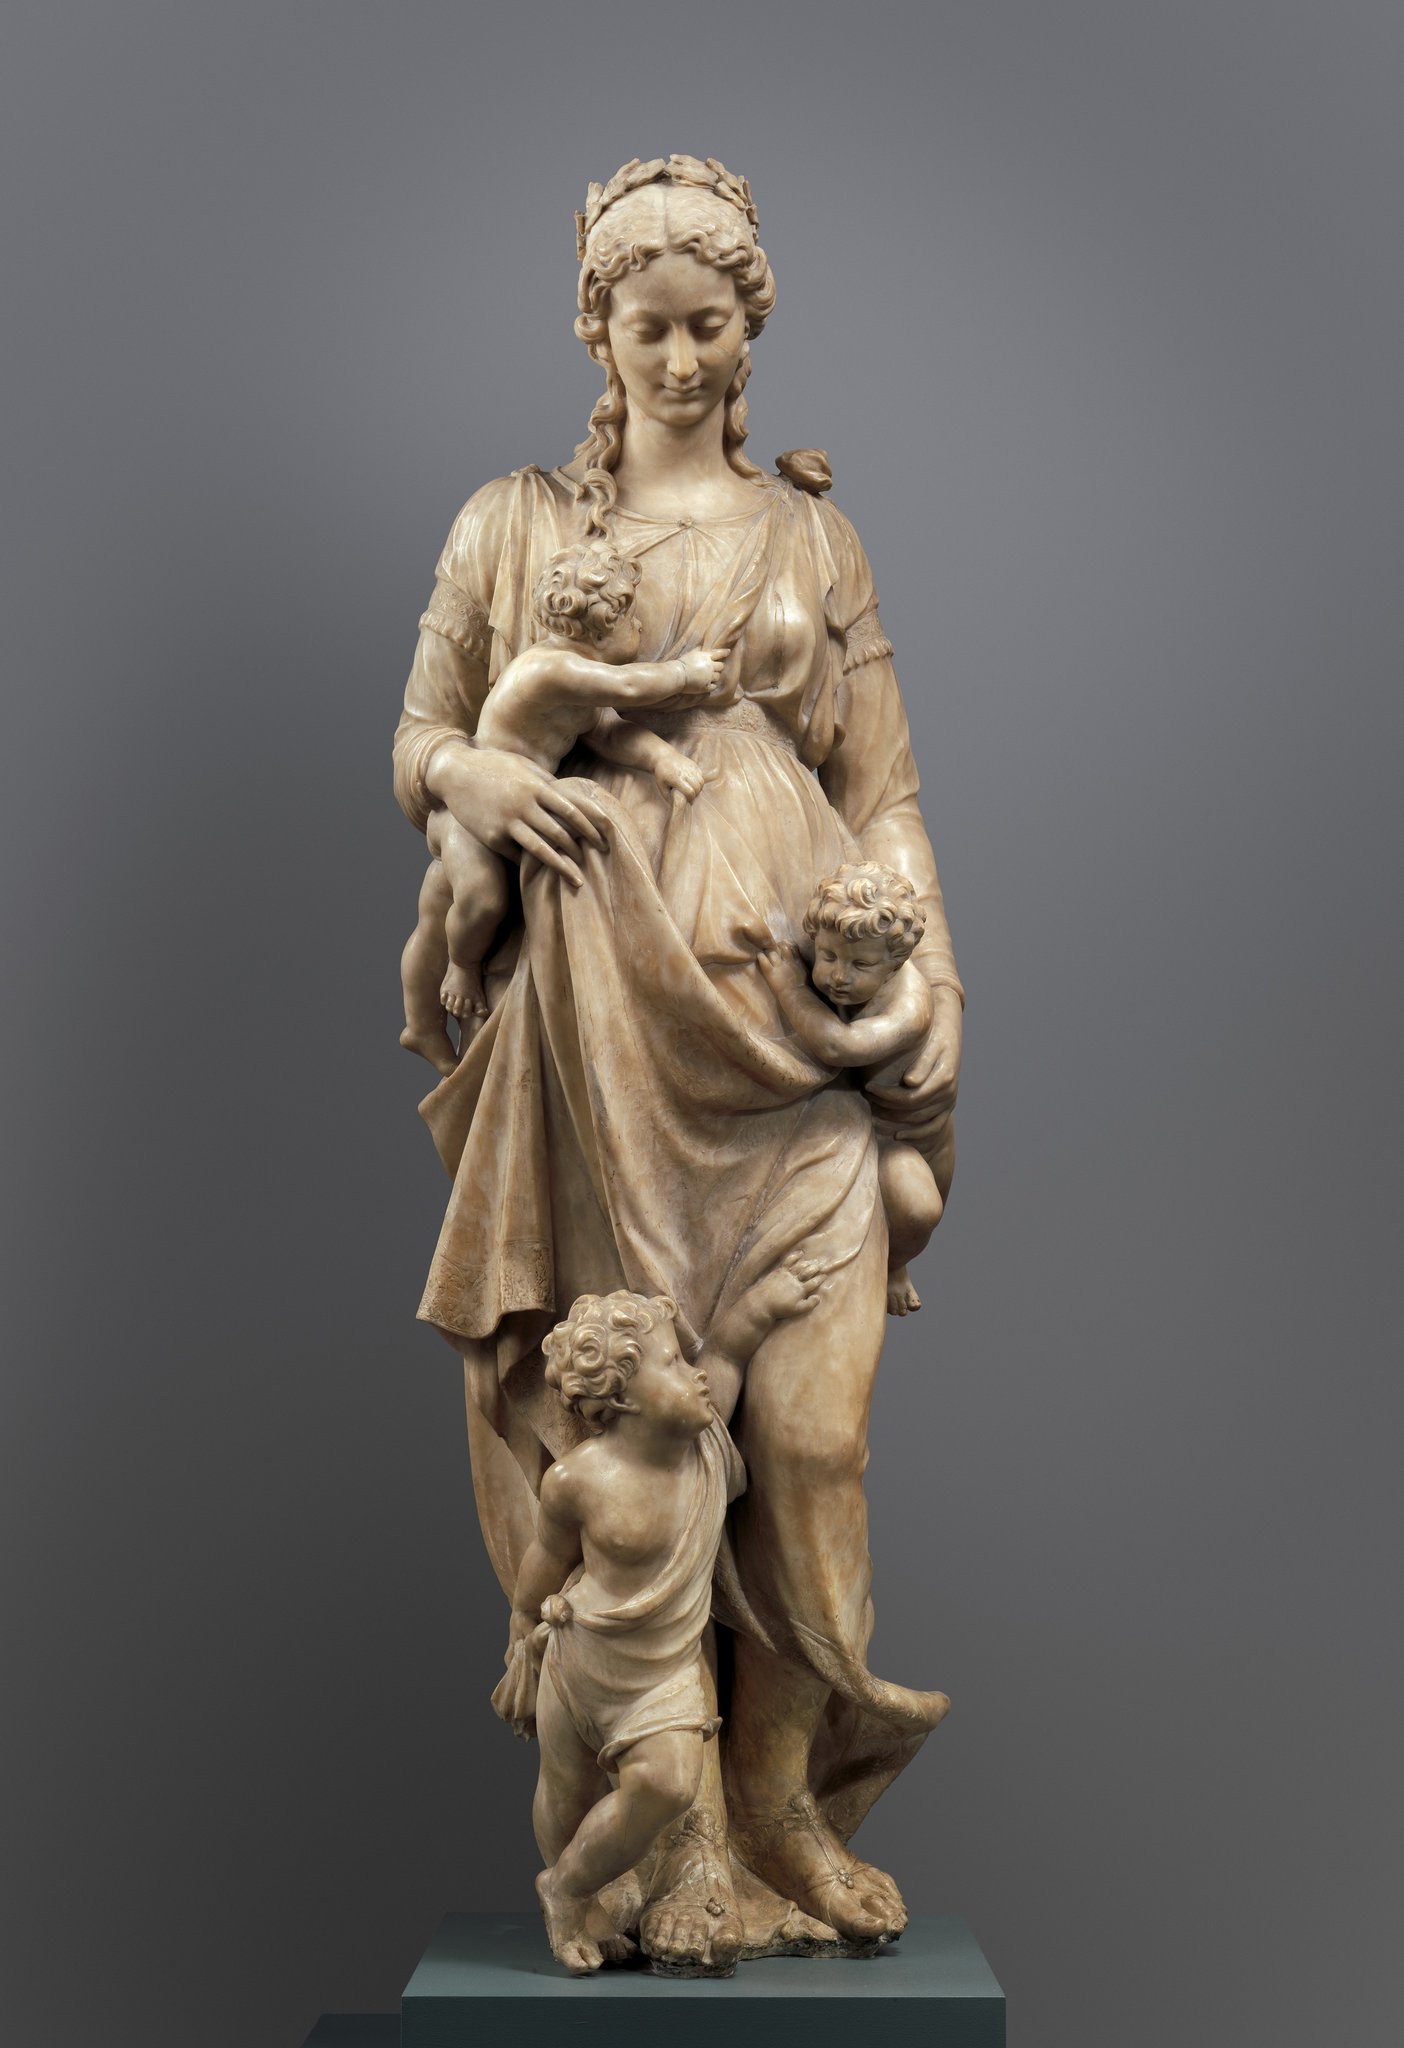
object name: group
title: Charity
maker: claudius floris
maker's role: artist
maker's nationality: flemish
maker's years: 1548-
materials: alabaster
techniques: gilding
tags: boys,women